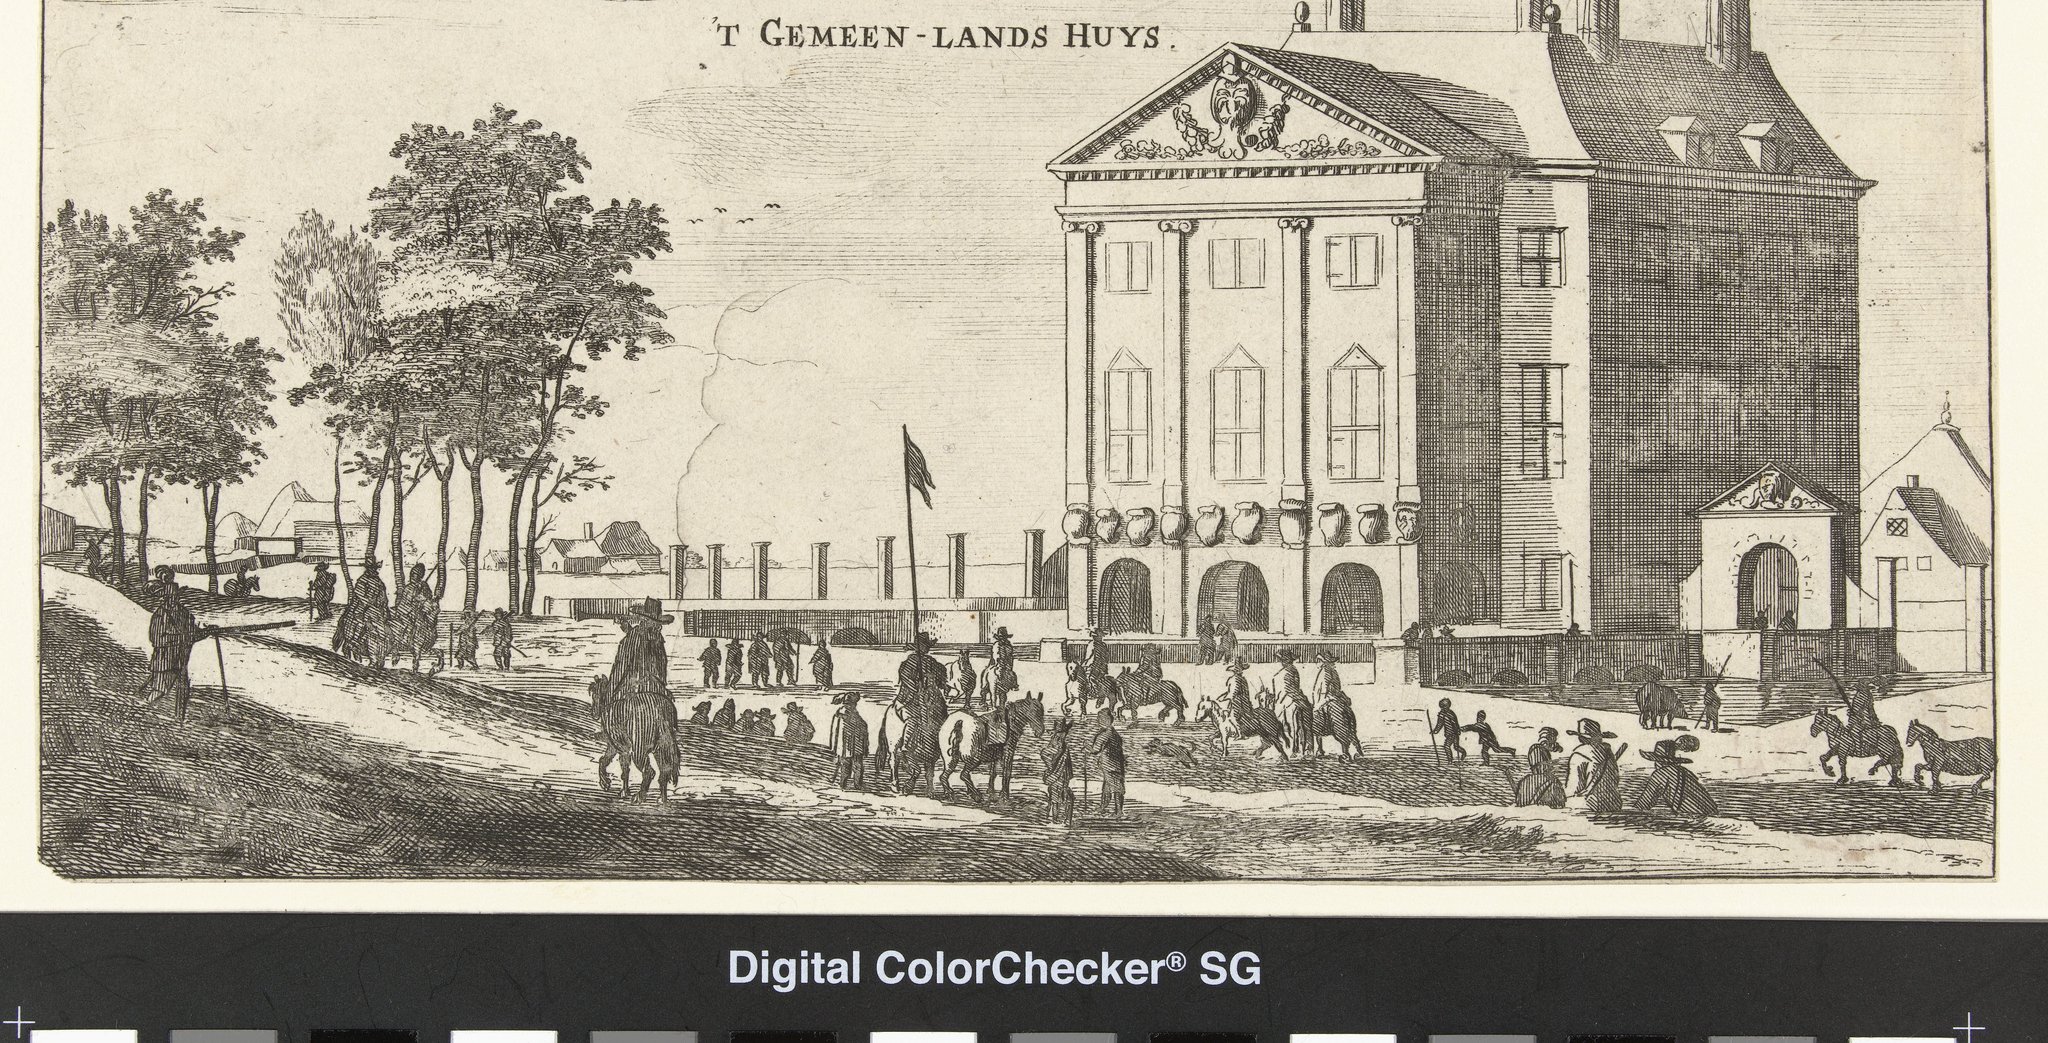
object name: print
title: 'T Gemeen-Lands Huys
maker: Anonymous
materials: paper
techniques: engraving, etching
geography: northern netherlands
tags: william ii (prince of orange)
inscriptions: collector's mark: Lugt 240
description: Gezicht op Huis Zwanenburg, het gemeenlandshuis van het hoogheemraadschap van Rijnland te Halfweg. Onderdeel van een serie van zes gezichten in de dorpen waar de troepen van prins Willem II ingekwartierd lagen tijdens het beleg van Amsterdam, van 30 juli tot 4 augustus 1650.